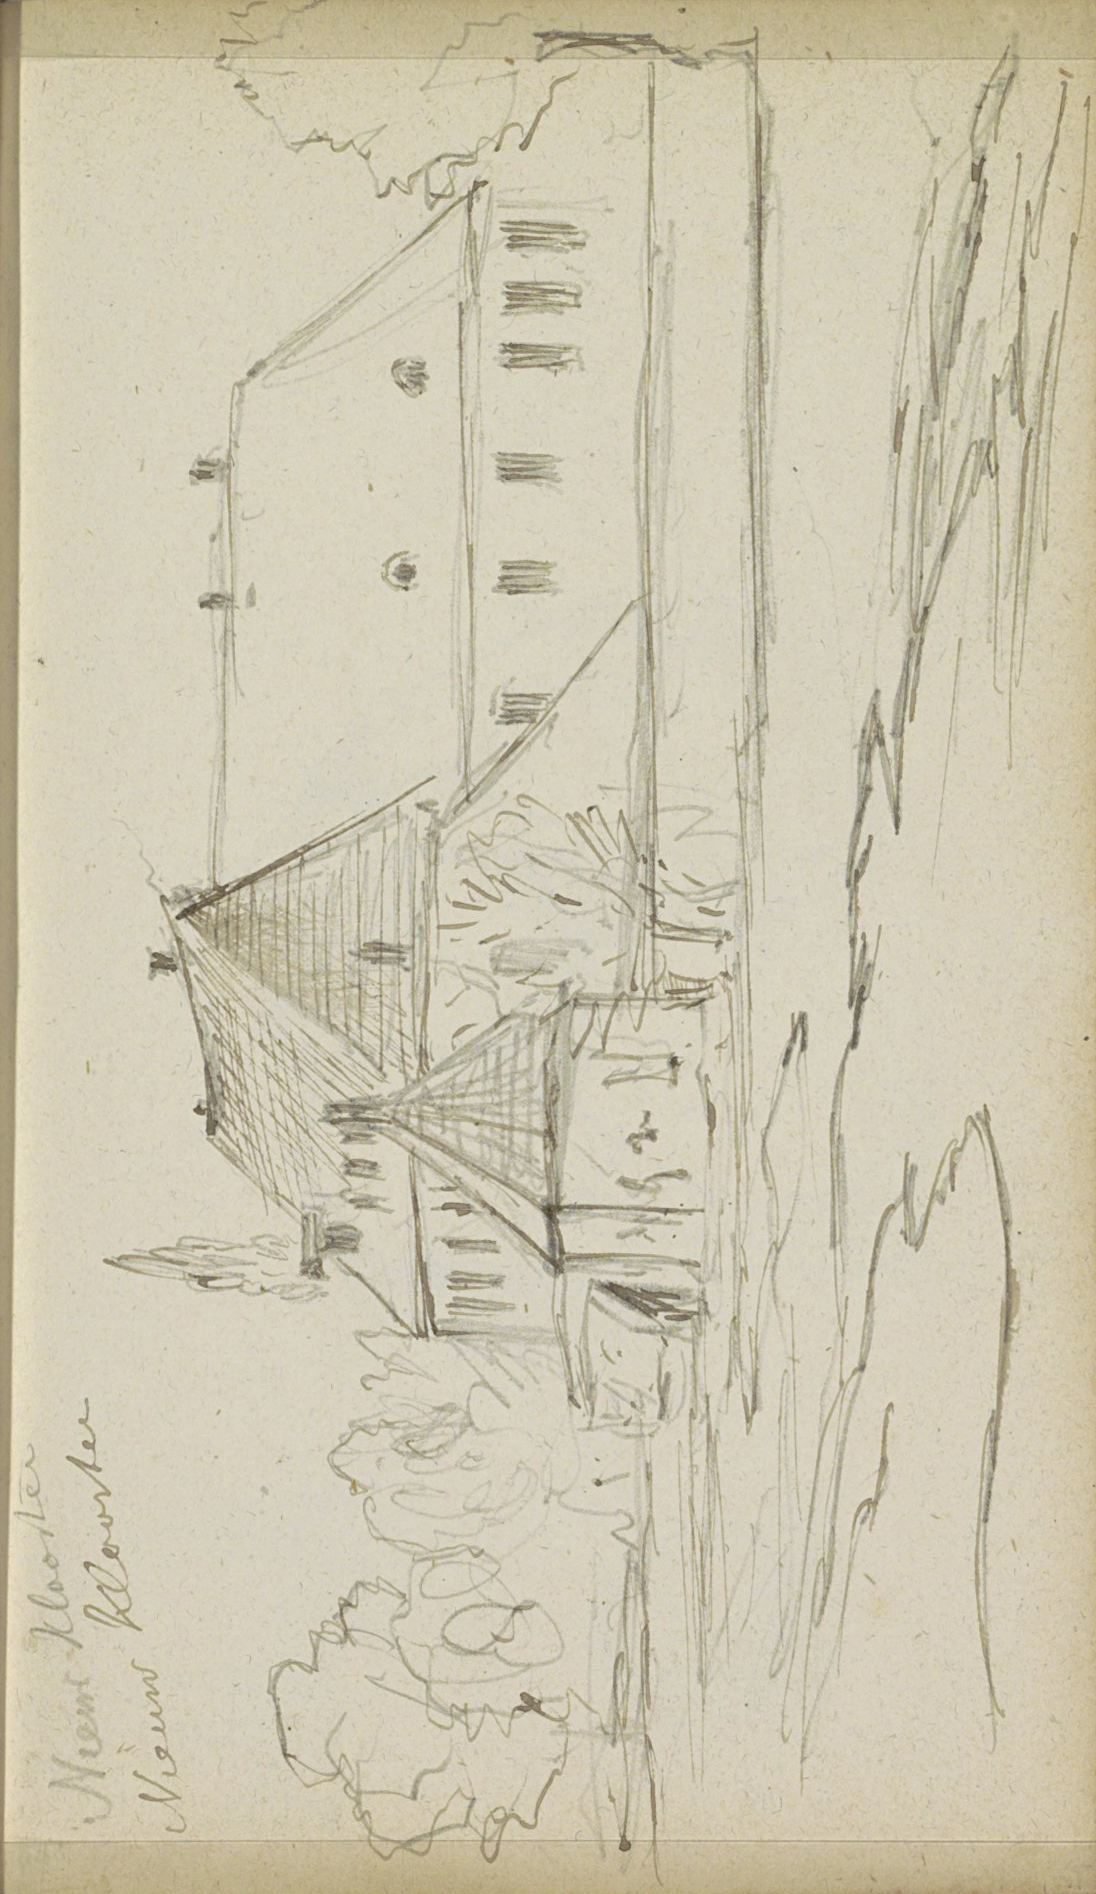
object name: sketchbook leaf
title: Klooster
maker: johannes tavenraat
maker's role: draughtsman, painter, print maker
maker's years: 1809-1881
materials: ink, paper, pencil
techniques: pen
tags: abbey, monastery, convent ~ roman catholic church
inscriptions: annotation: ‘Nieuw Klooster/ Nieuw Klooster’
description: Blad 35 recto uit een schetsboek met 88 bladen.